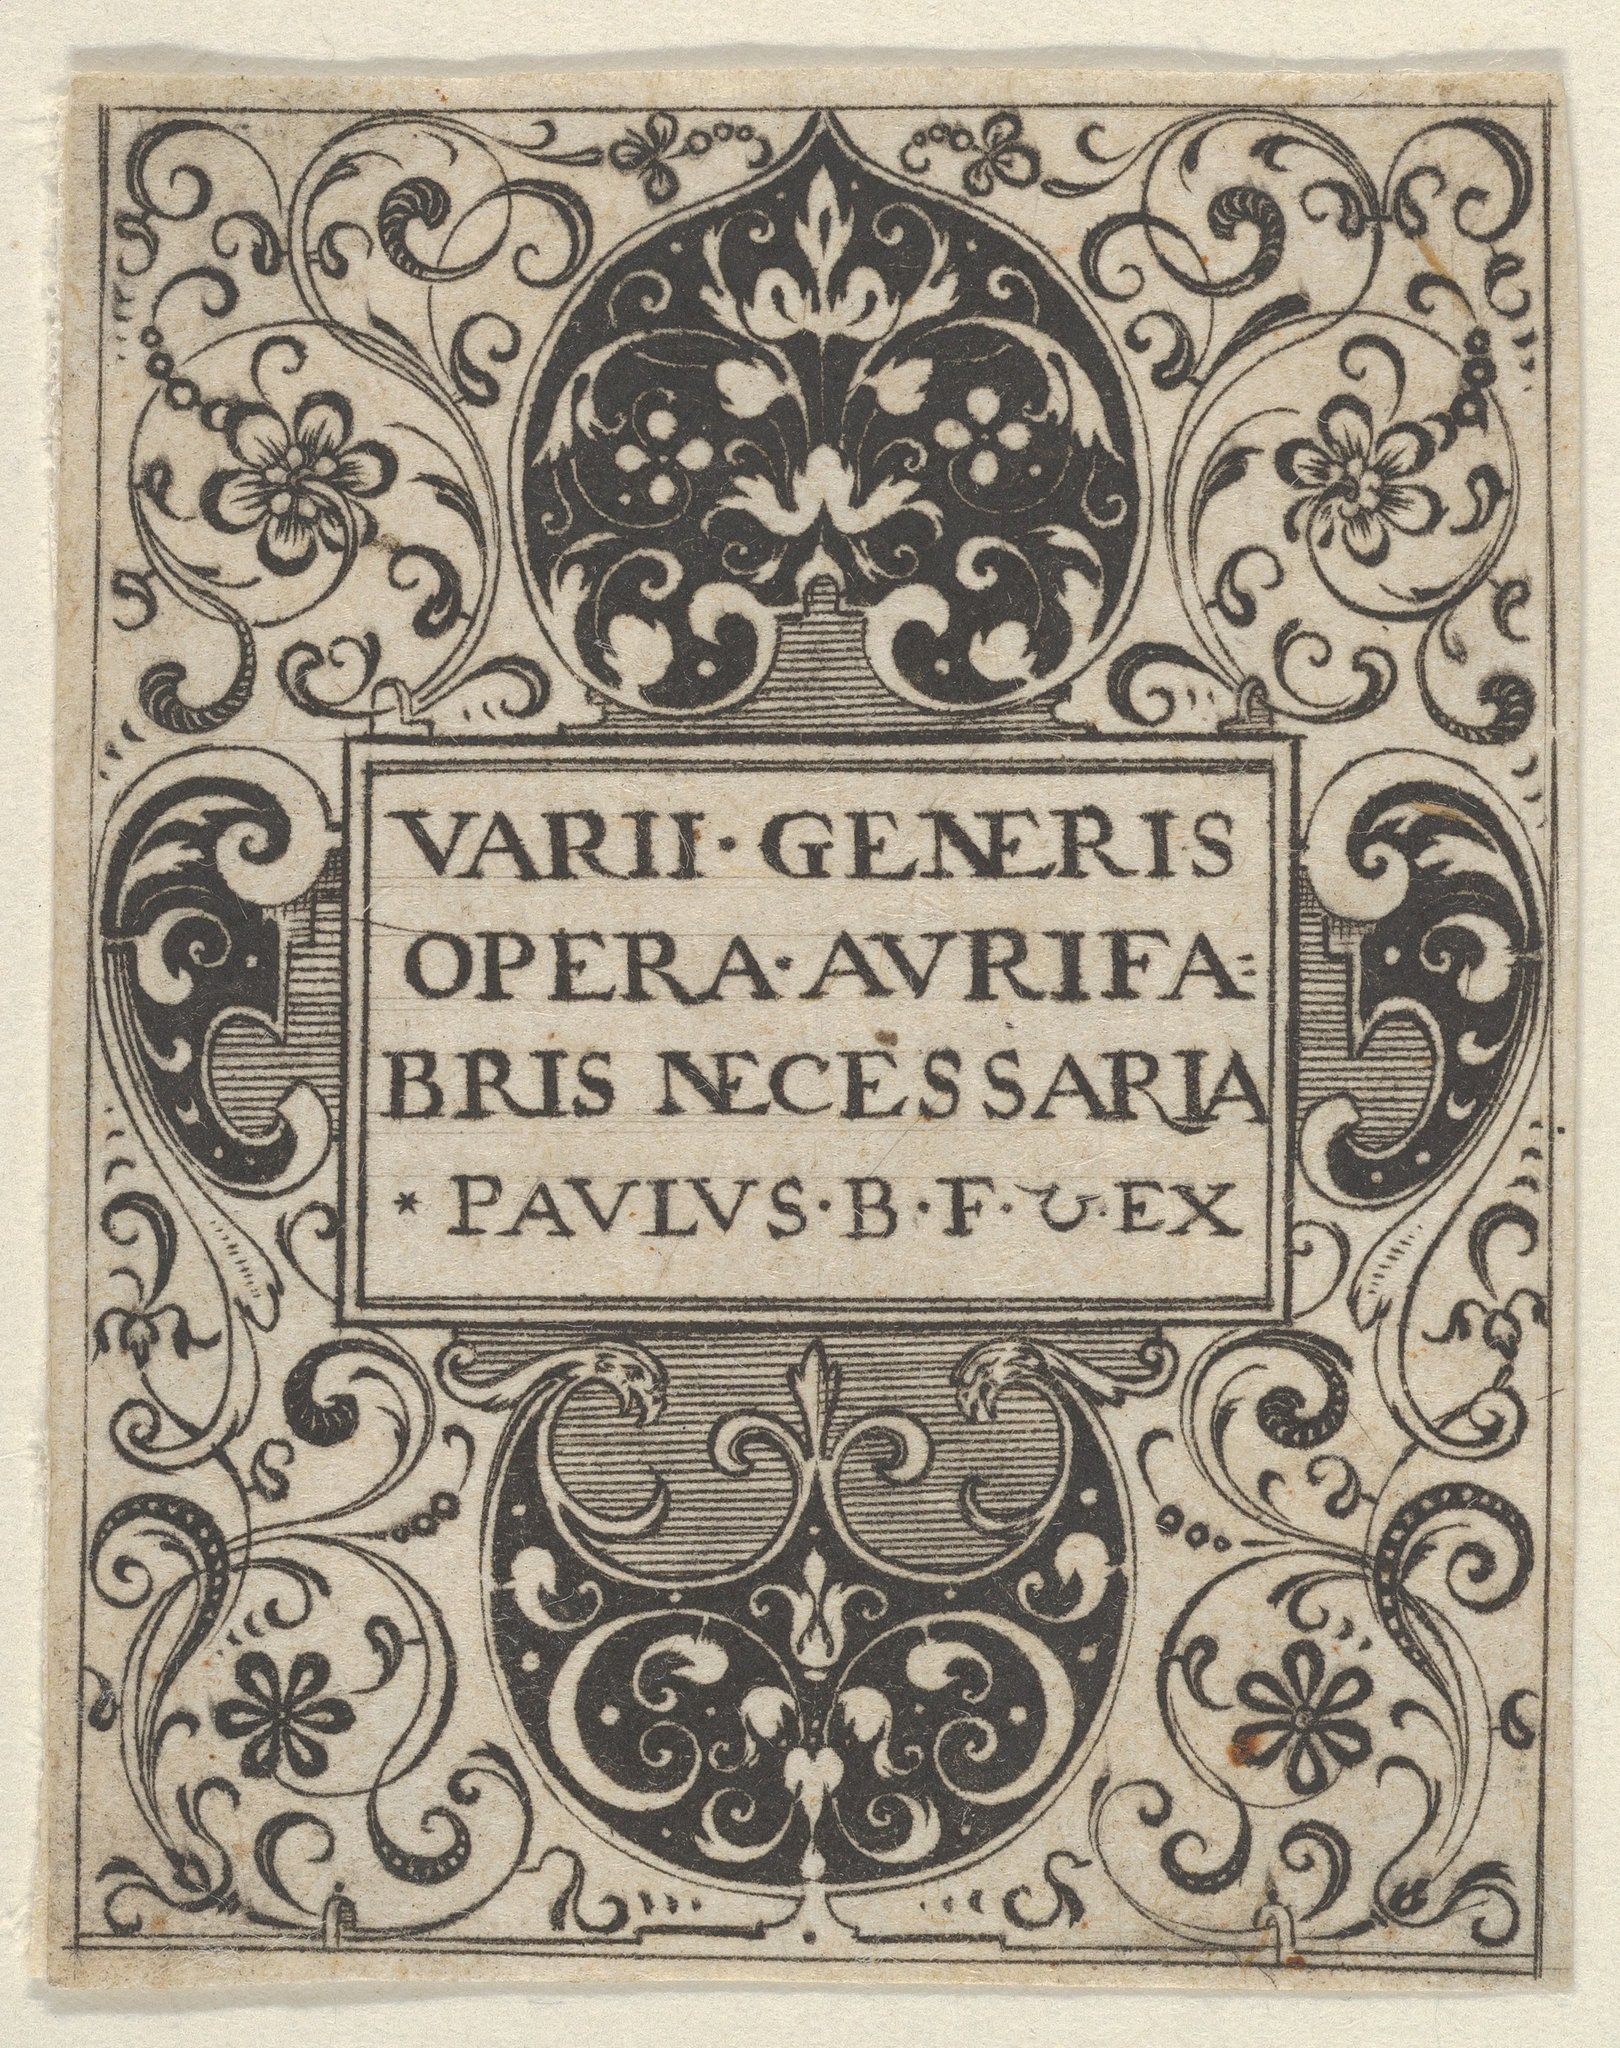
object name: print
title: Title Page, from "Varii Generis Opera Aurifabris Necessaria"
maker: paul birckenhultz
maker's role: artist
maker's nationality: german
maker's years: 1561-1639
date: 1600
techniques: embroidery, engraving